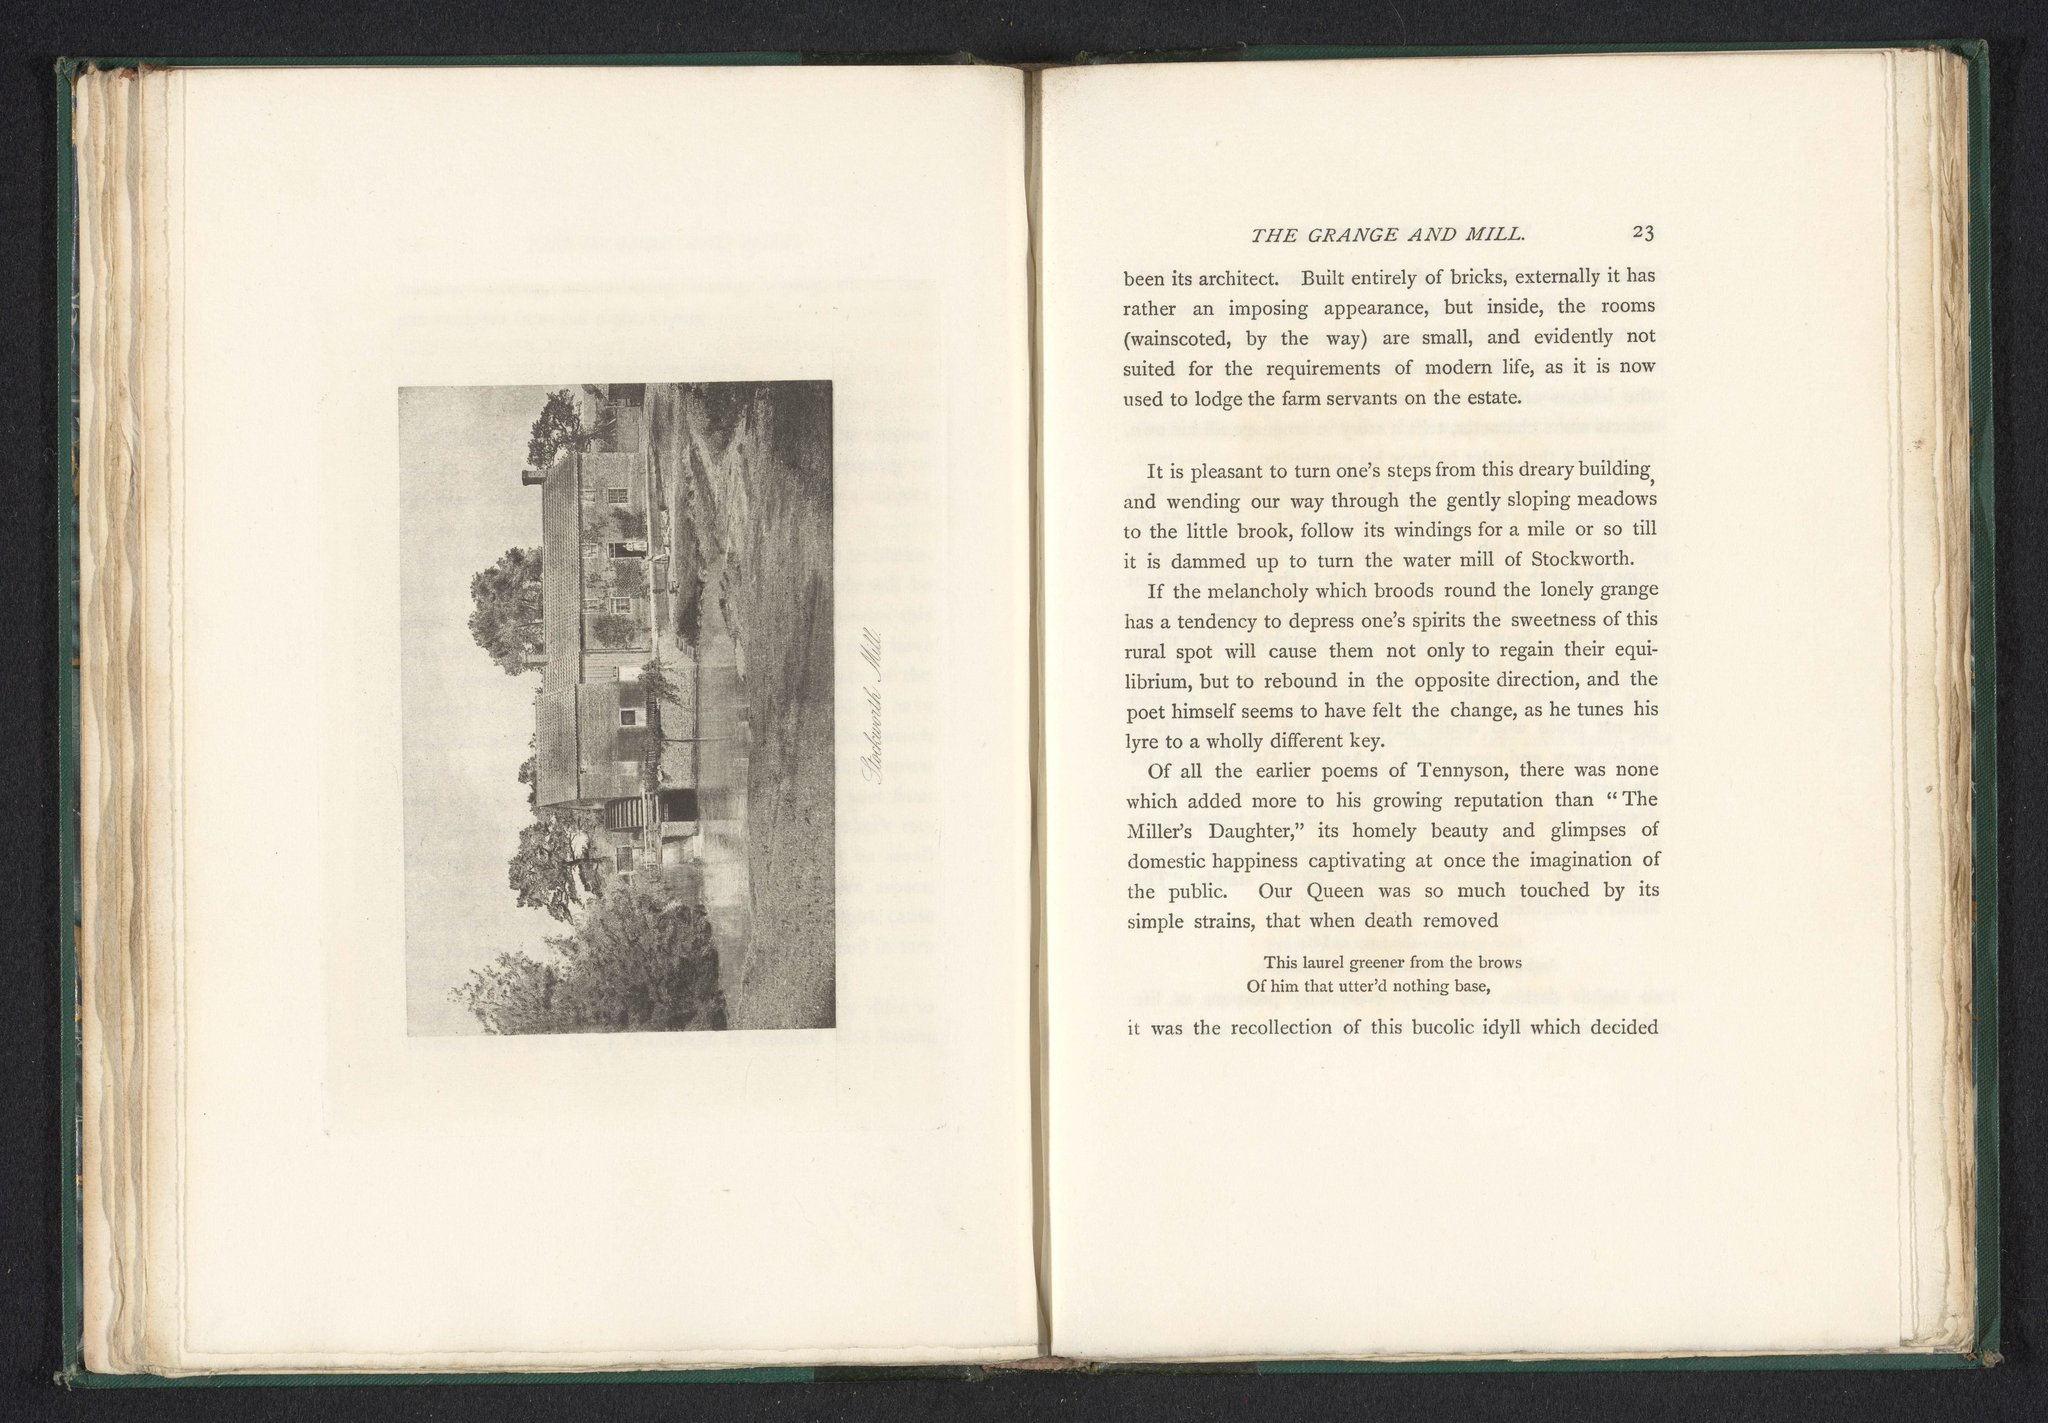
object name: photomechanical print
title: Stockworth Mill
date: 1884-1889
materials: paper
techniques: photoaquatint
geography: hagworthingham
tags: watermill in landscape, façade (of house or building)